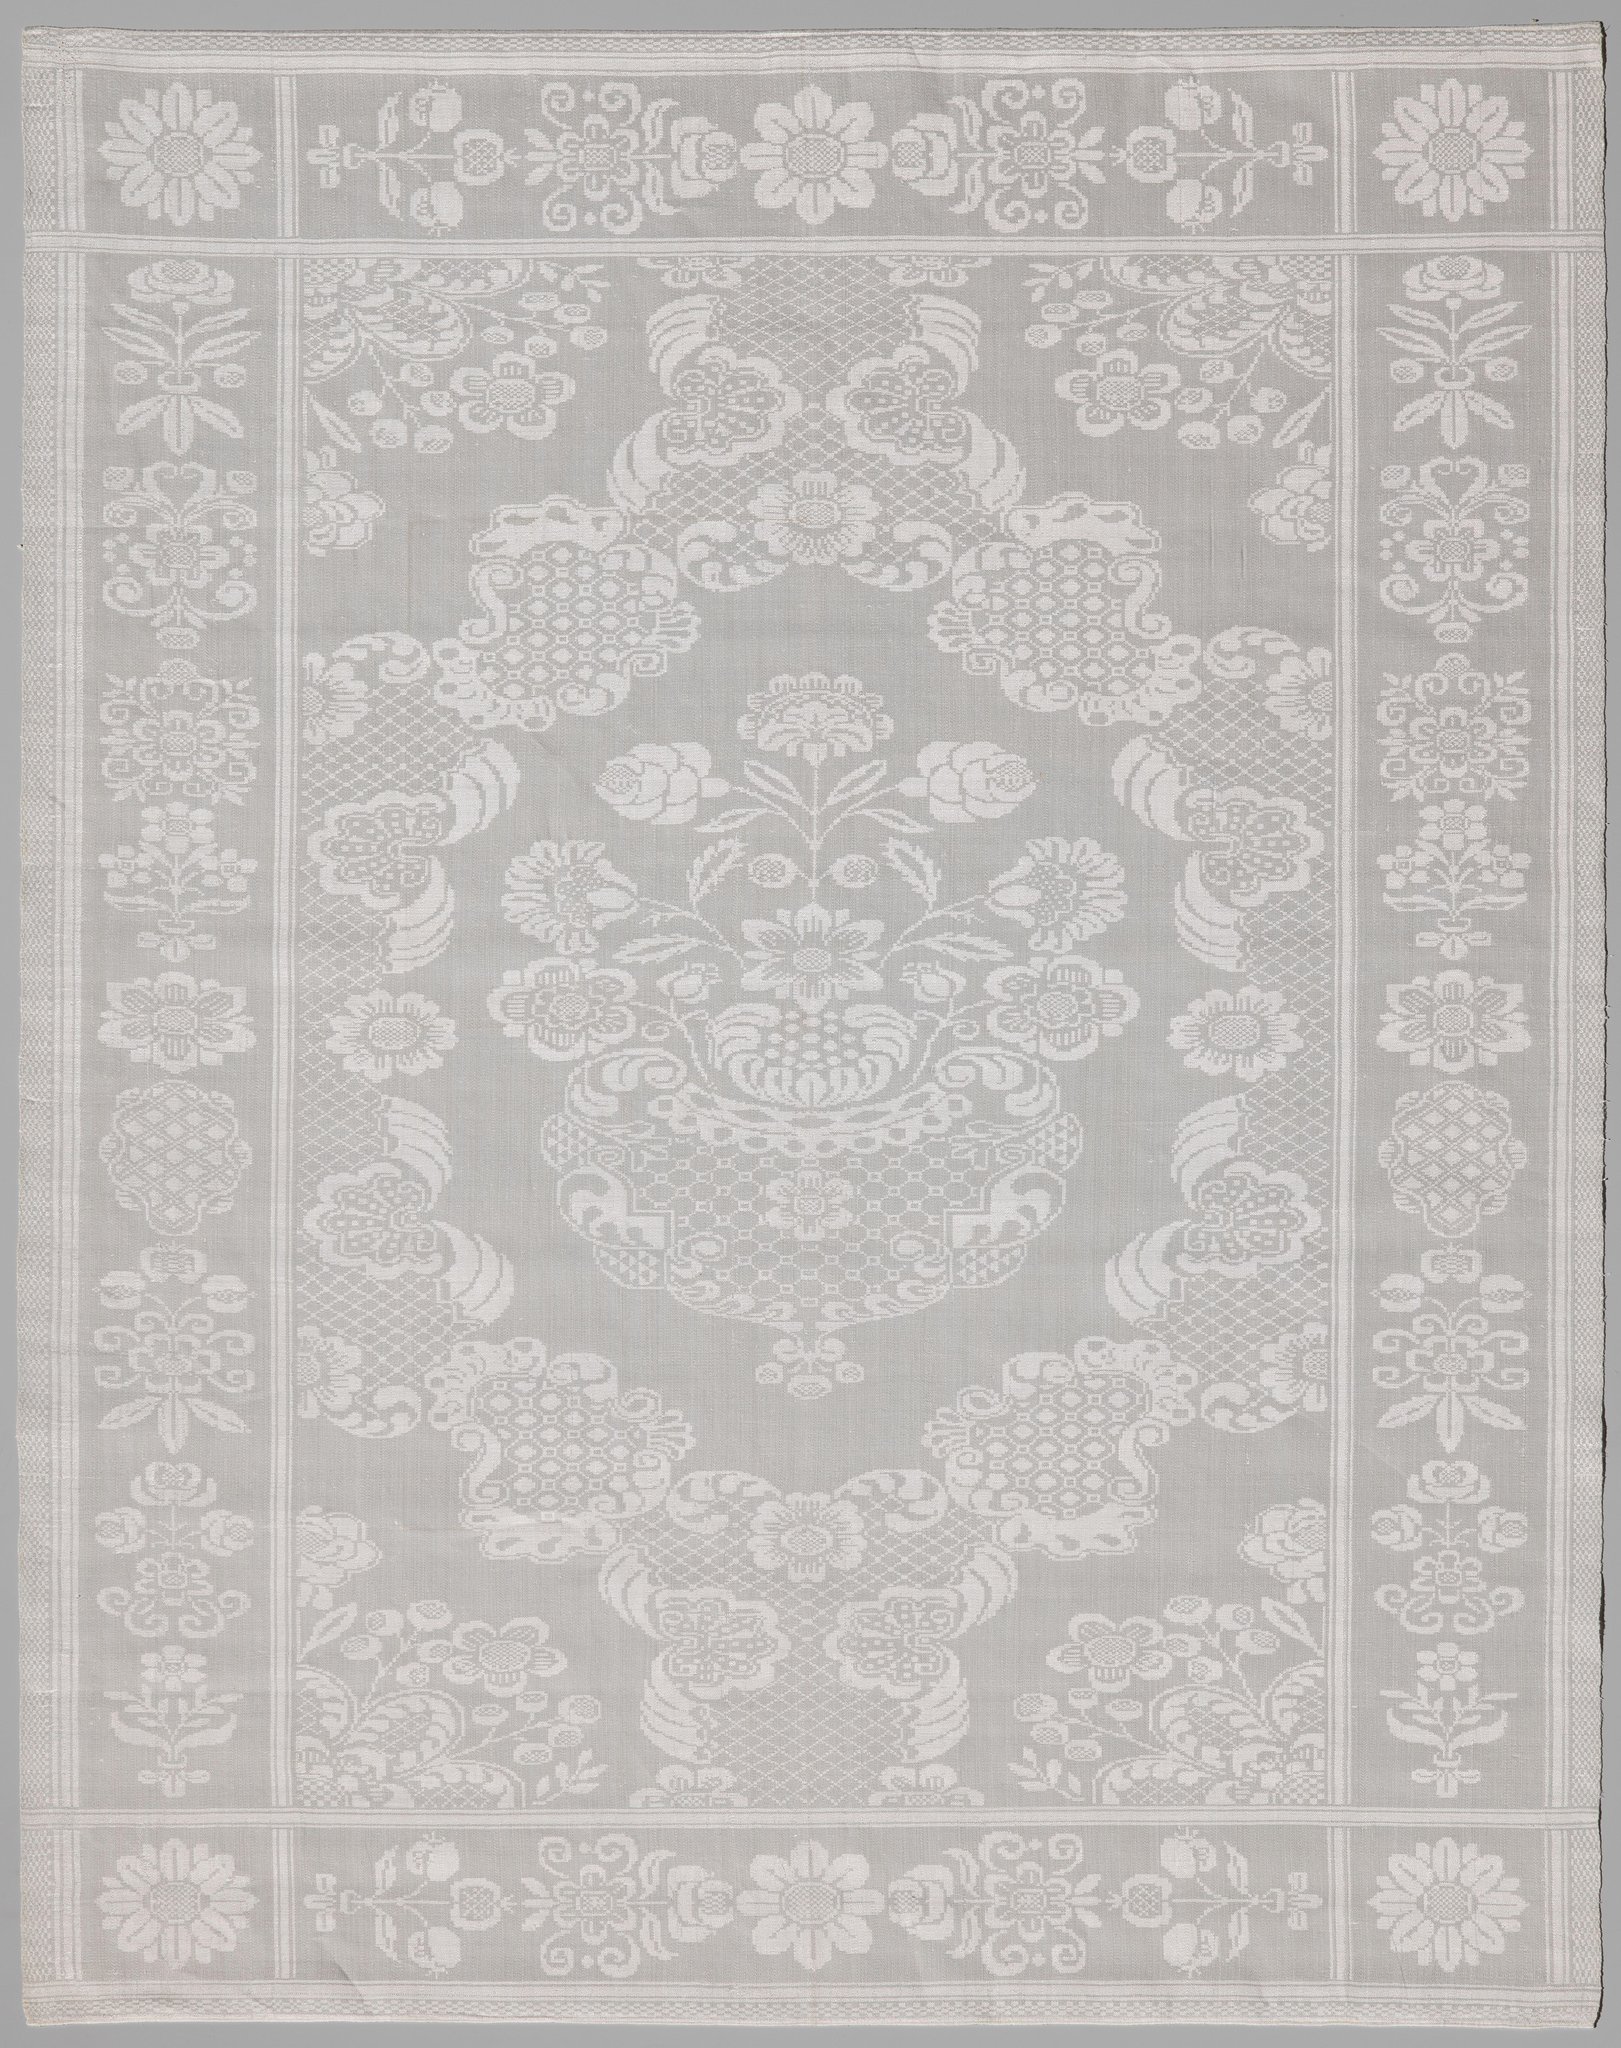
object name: napkin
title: Servet van wit linnendamast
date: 1764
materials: linen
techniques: damask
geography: northern netherlands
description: Wit linnendamasten servet met z.g. kantpatroon, merk kroon G 12.